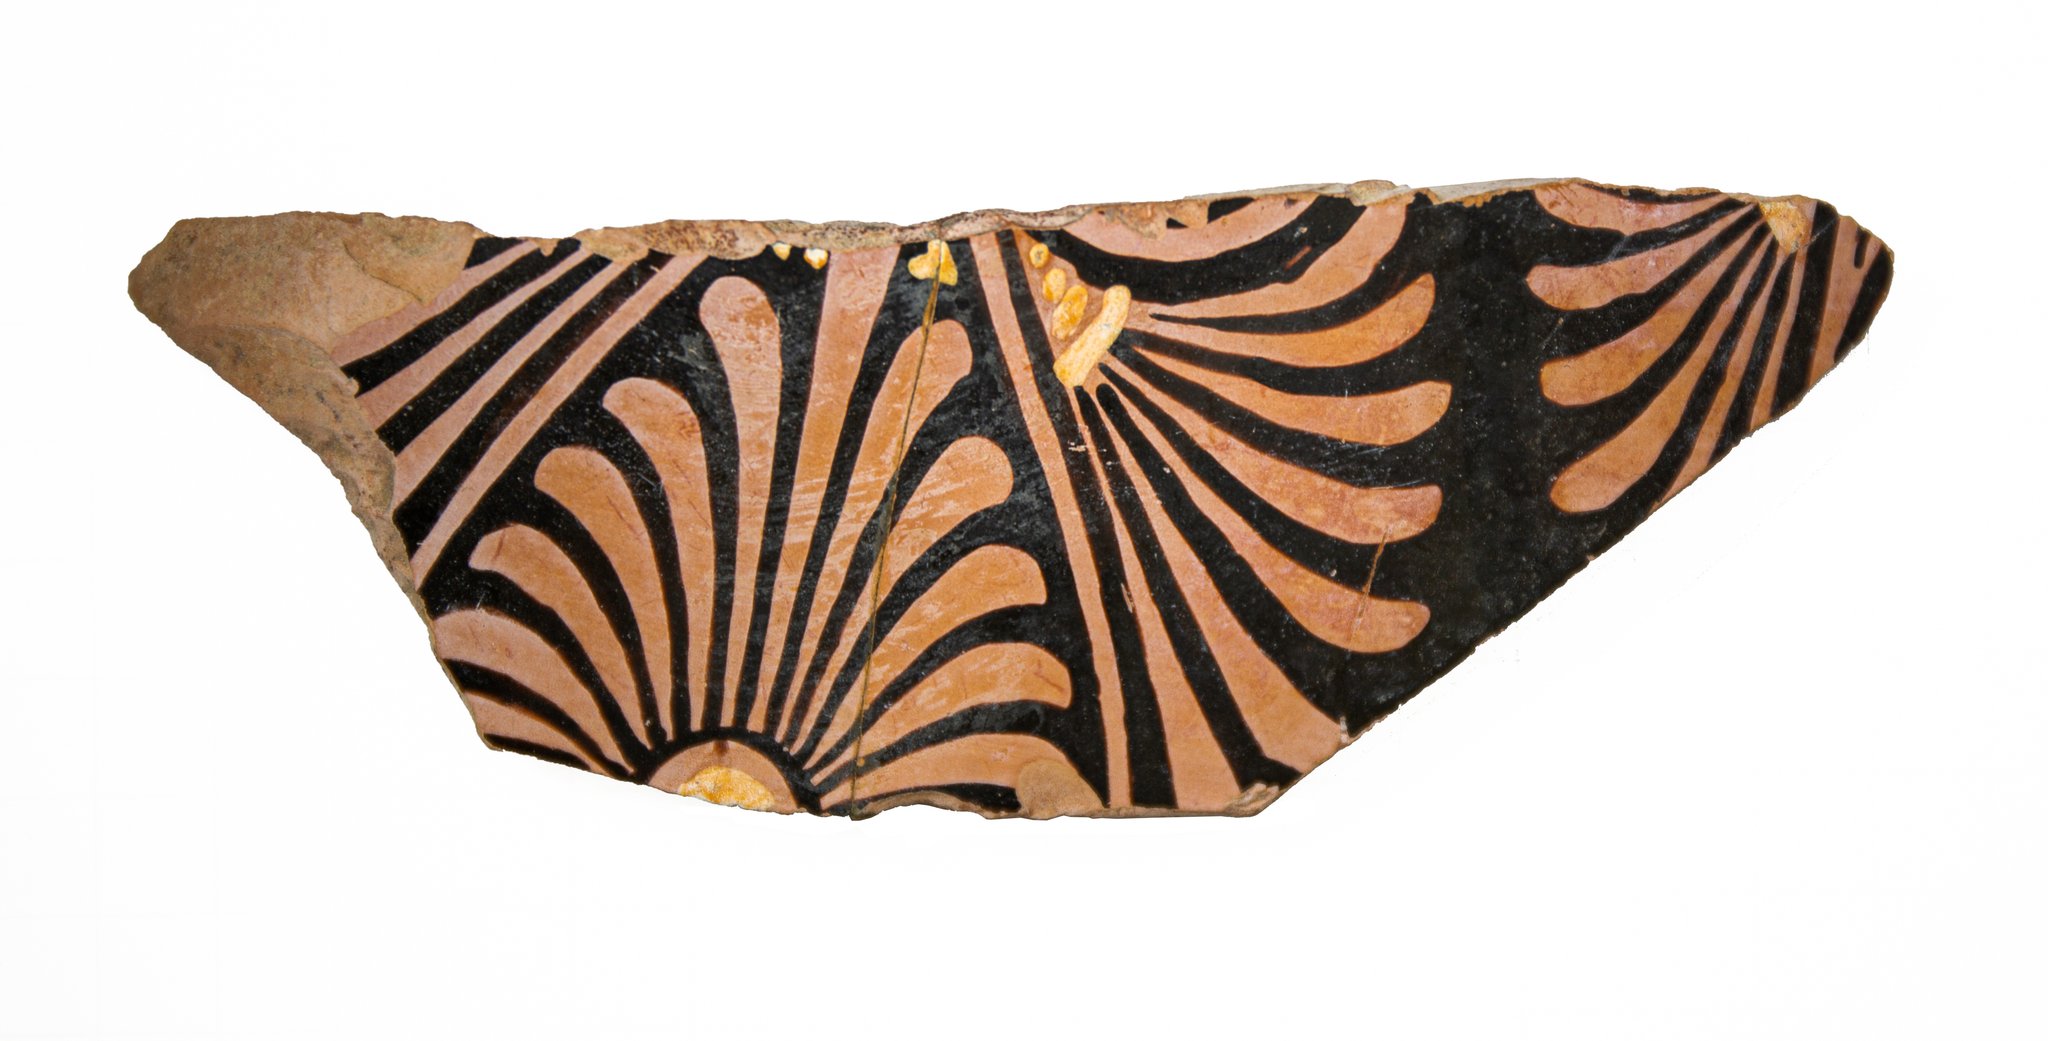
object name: volute krater fragment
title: Volute-krater fragment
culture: greek, south italian, apulian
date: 360-340 BCE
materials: terracotta